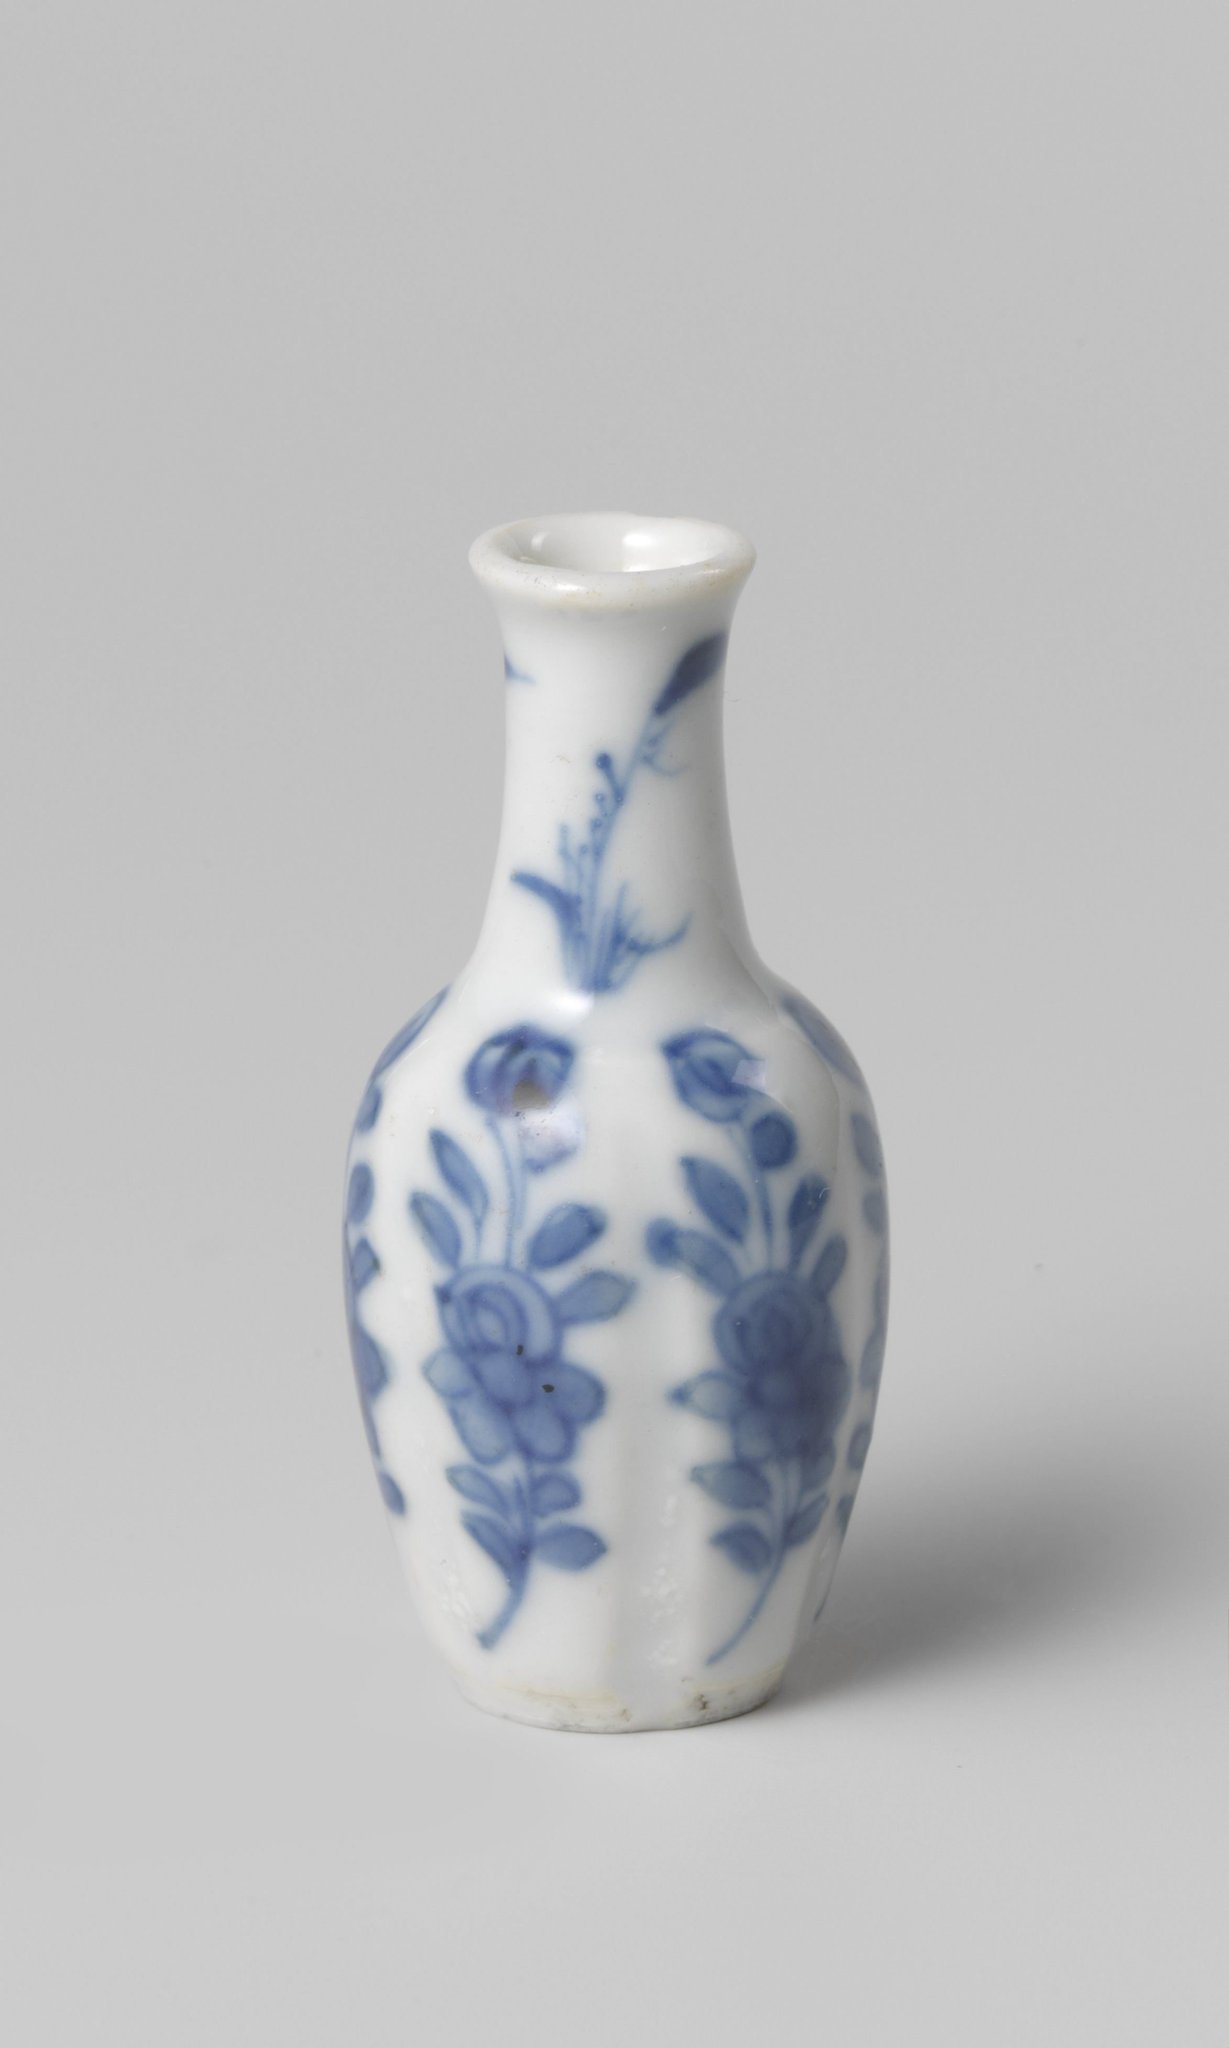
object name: vase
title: Miniature bottle vase with flowering plants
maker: Anonymous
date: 1675-1724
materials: cobalt, glaze, paint, porcelain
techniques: firing, turning, vitrification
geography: china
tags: ornament derived from plant forms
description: Miniatuur flesvormige vaas van porselein met een zeslobbig lichaam, beschilderd in onderglazuur blauw. Op de buik en nek bloeiende planten. Blauw-wit.